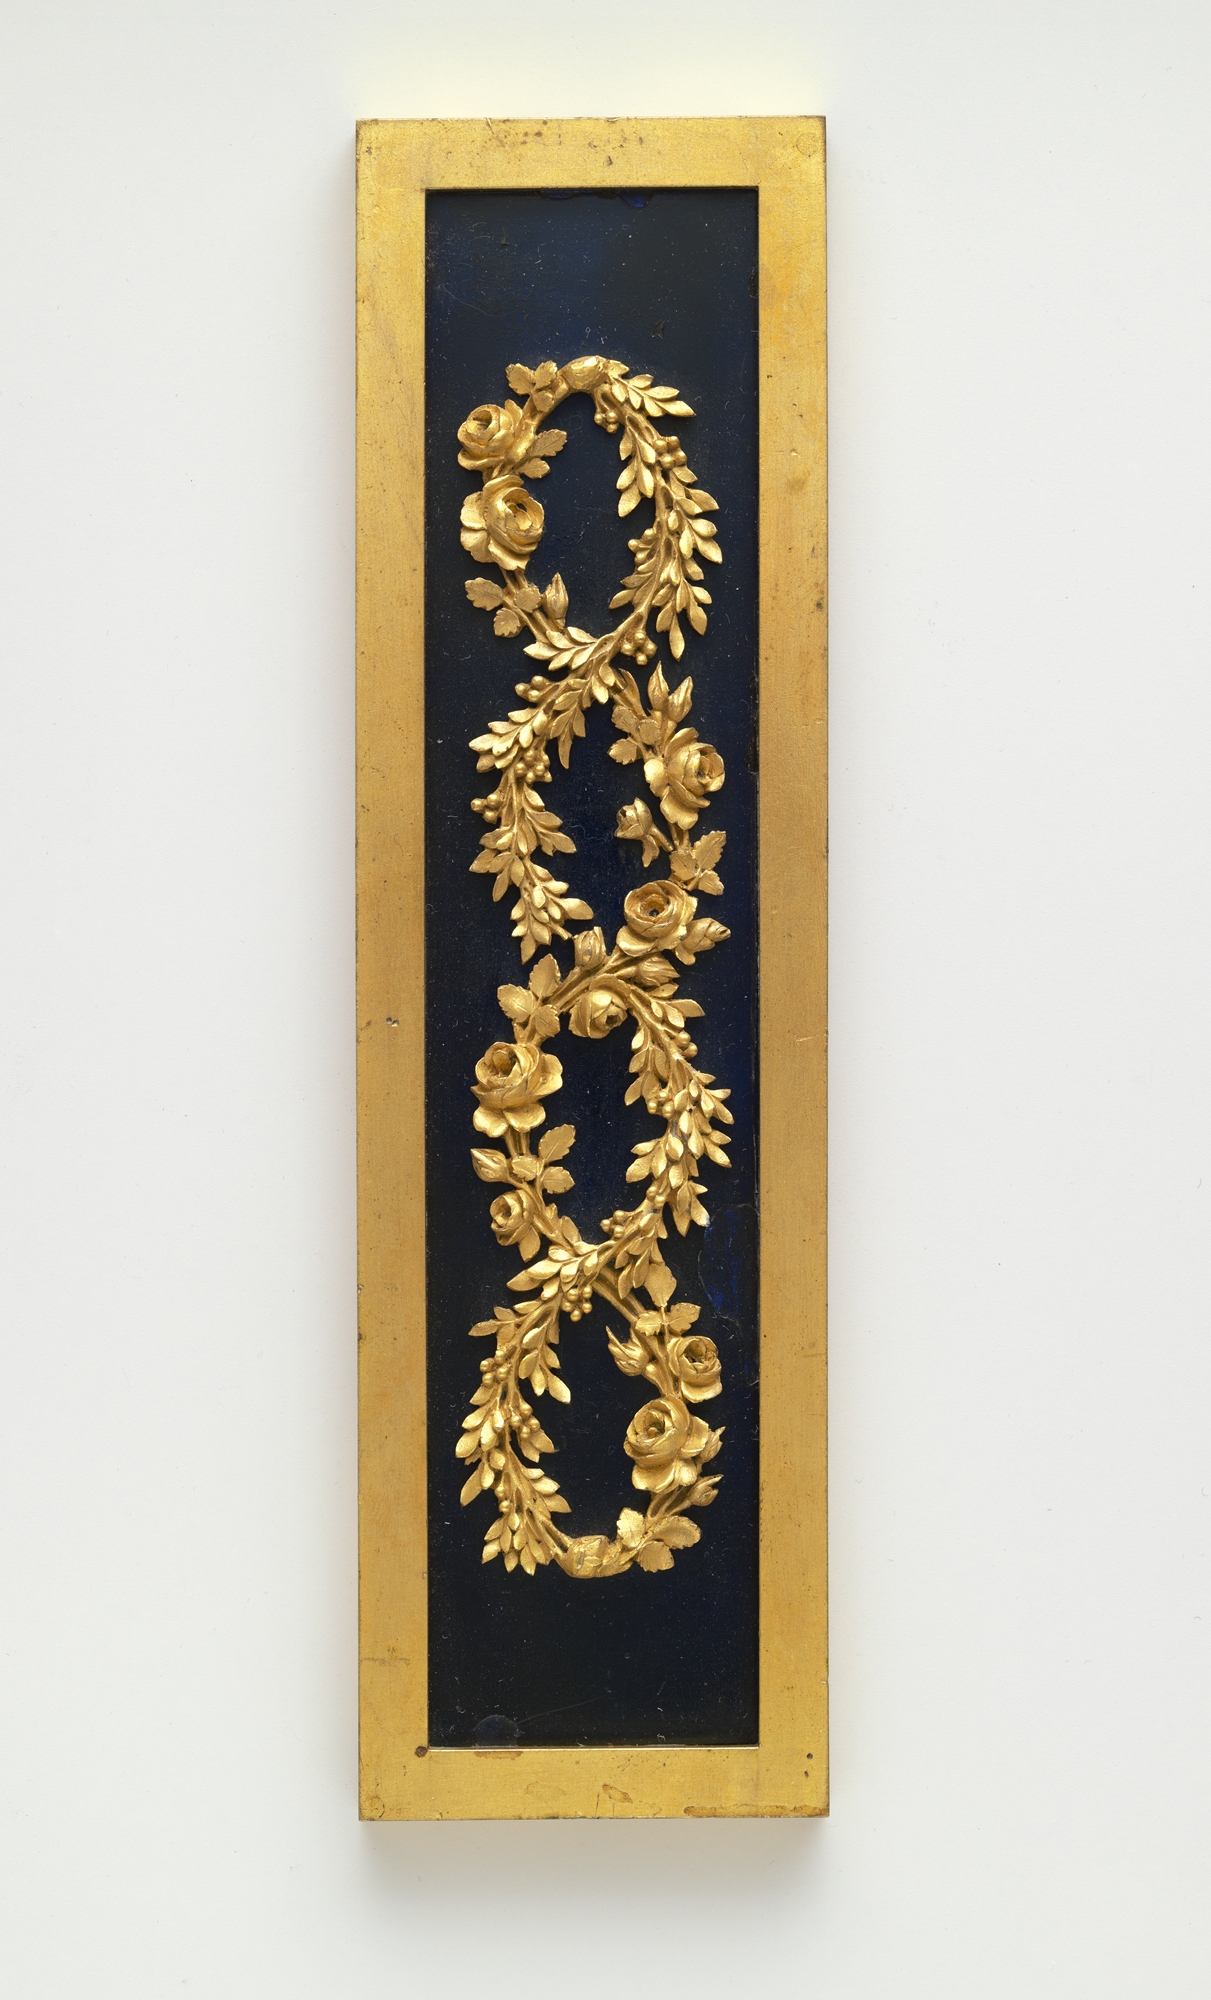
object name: ornament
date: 1701-1800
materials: enamel, gilt bronze